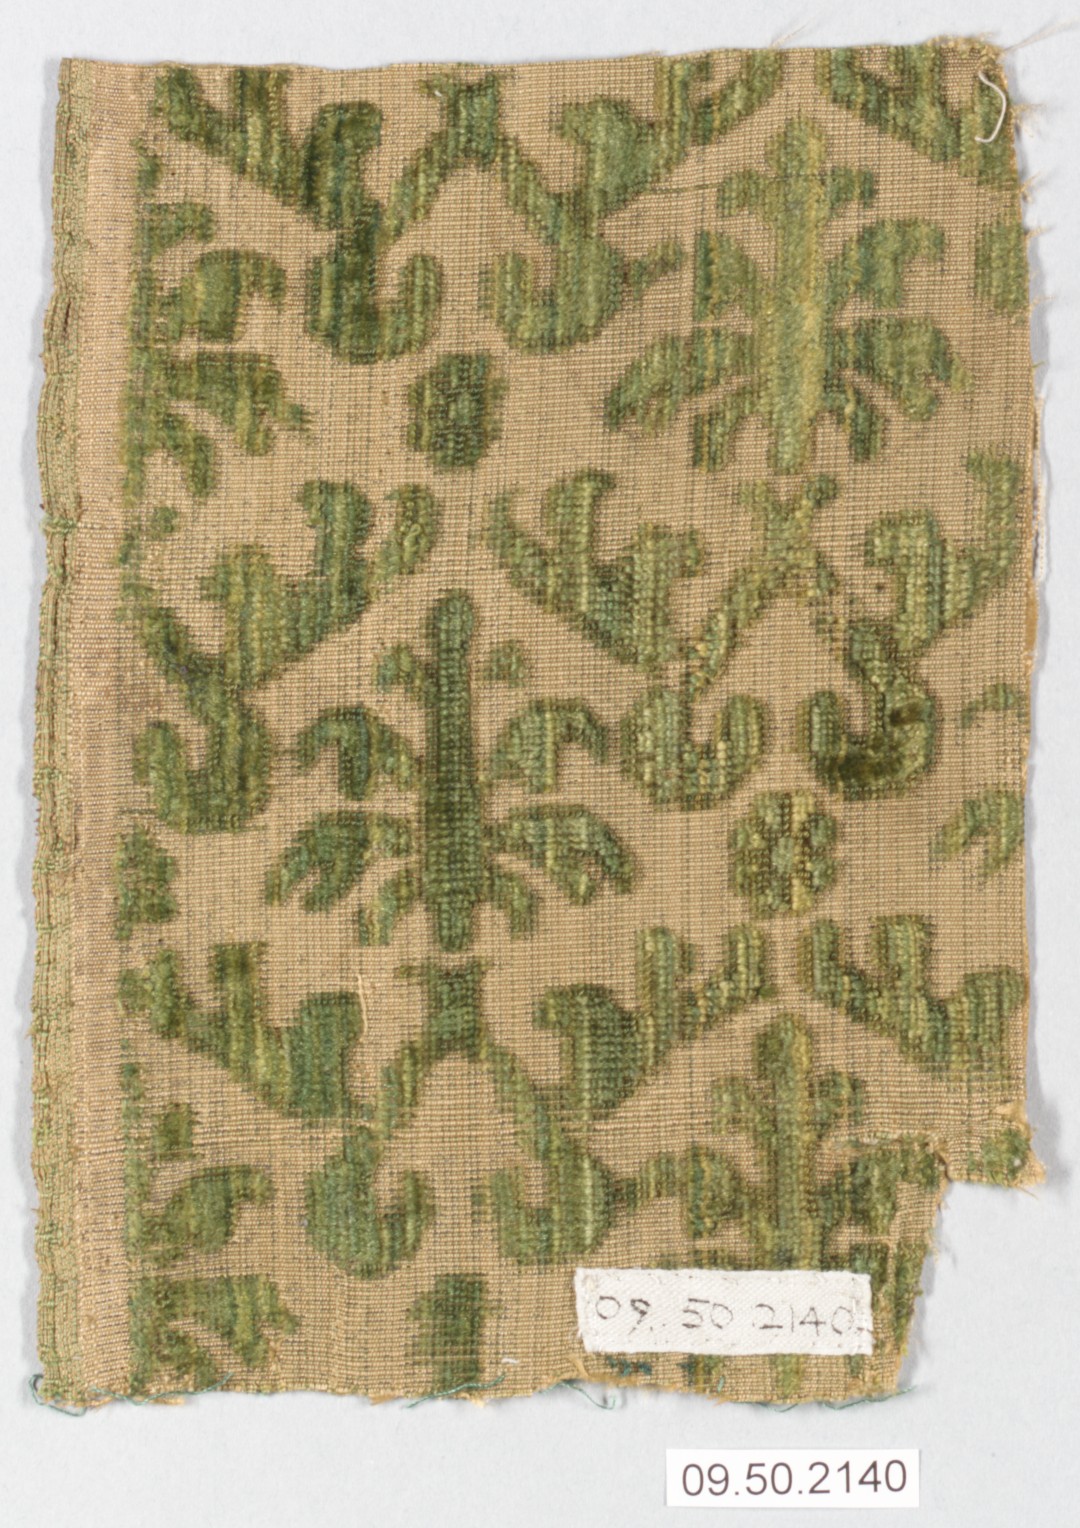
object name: piece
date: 1501-1700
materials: metal thread, silk